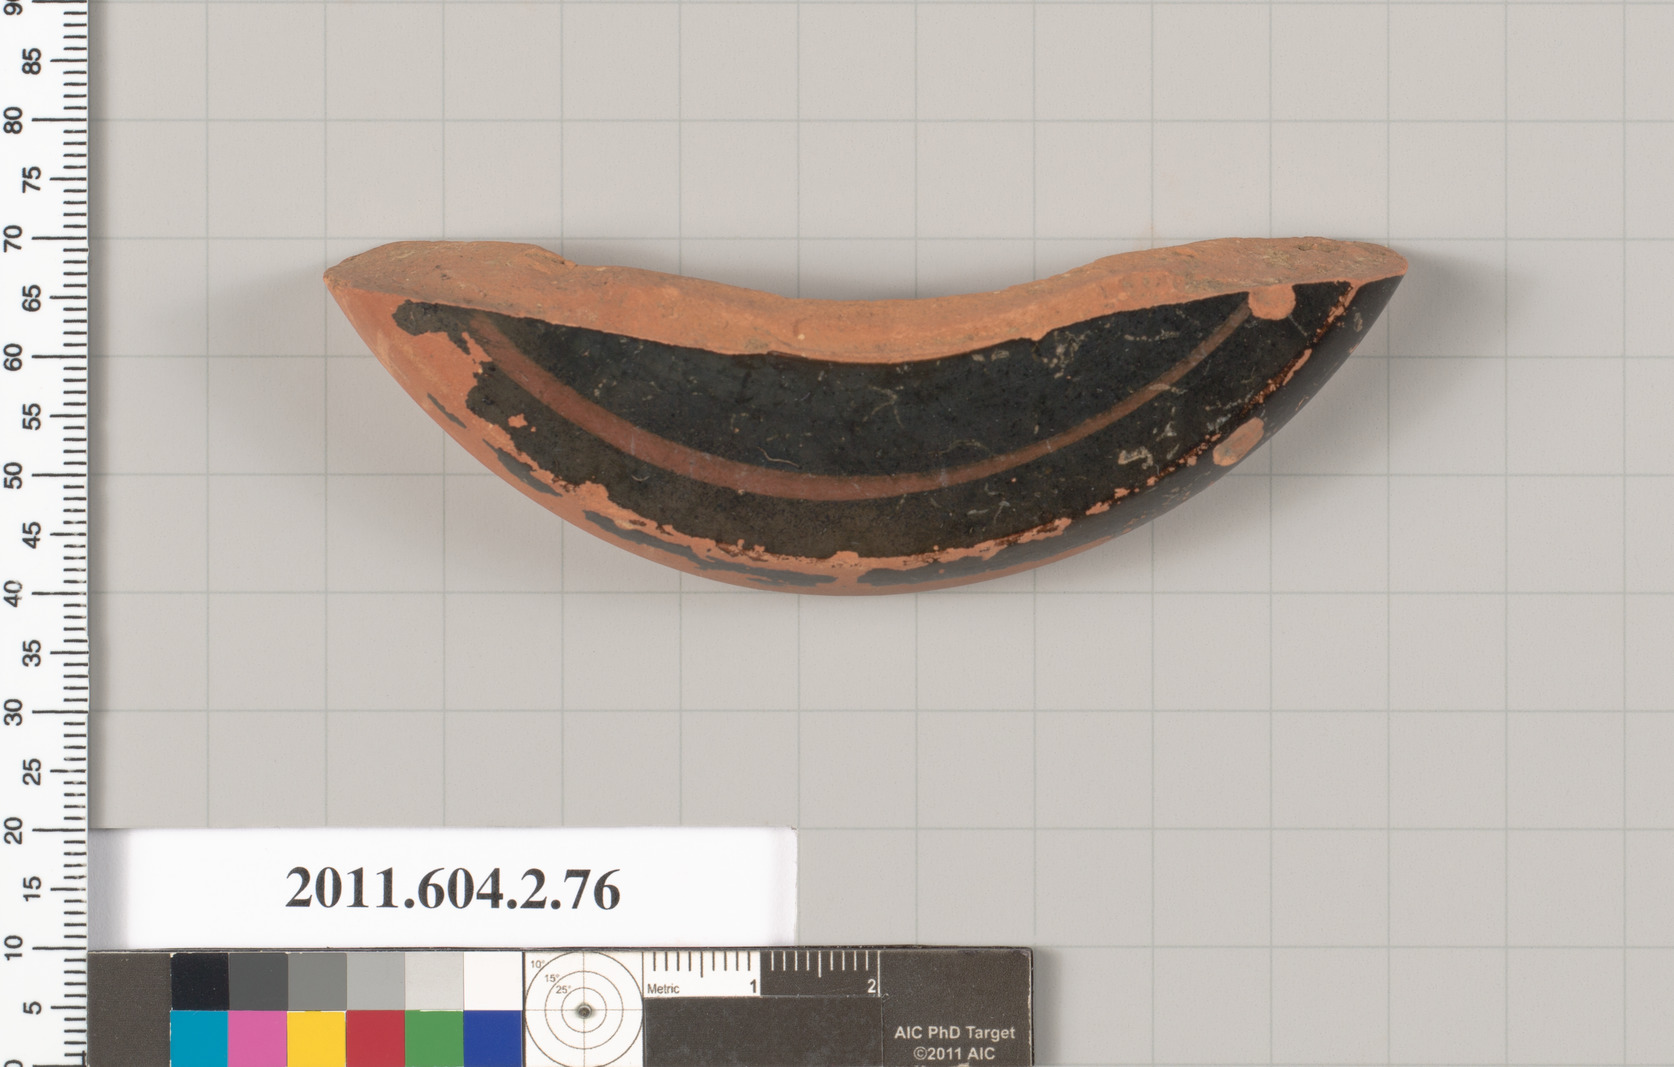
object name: amphora fragment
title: Terracotta fragment of an amphora (jar)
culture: greek, attic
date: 534-468 BCE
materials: terracotta